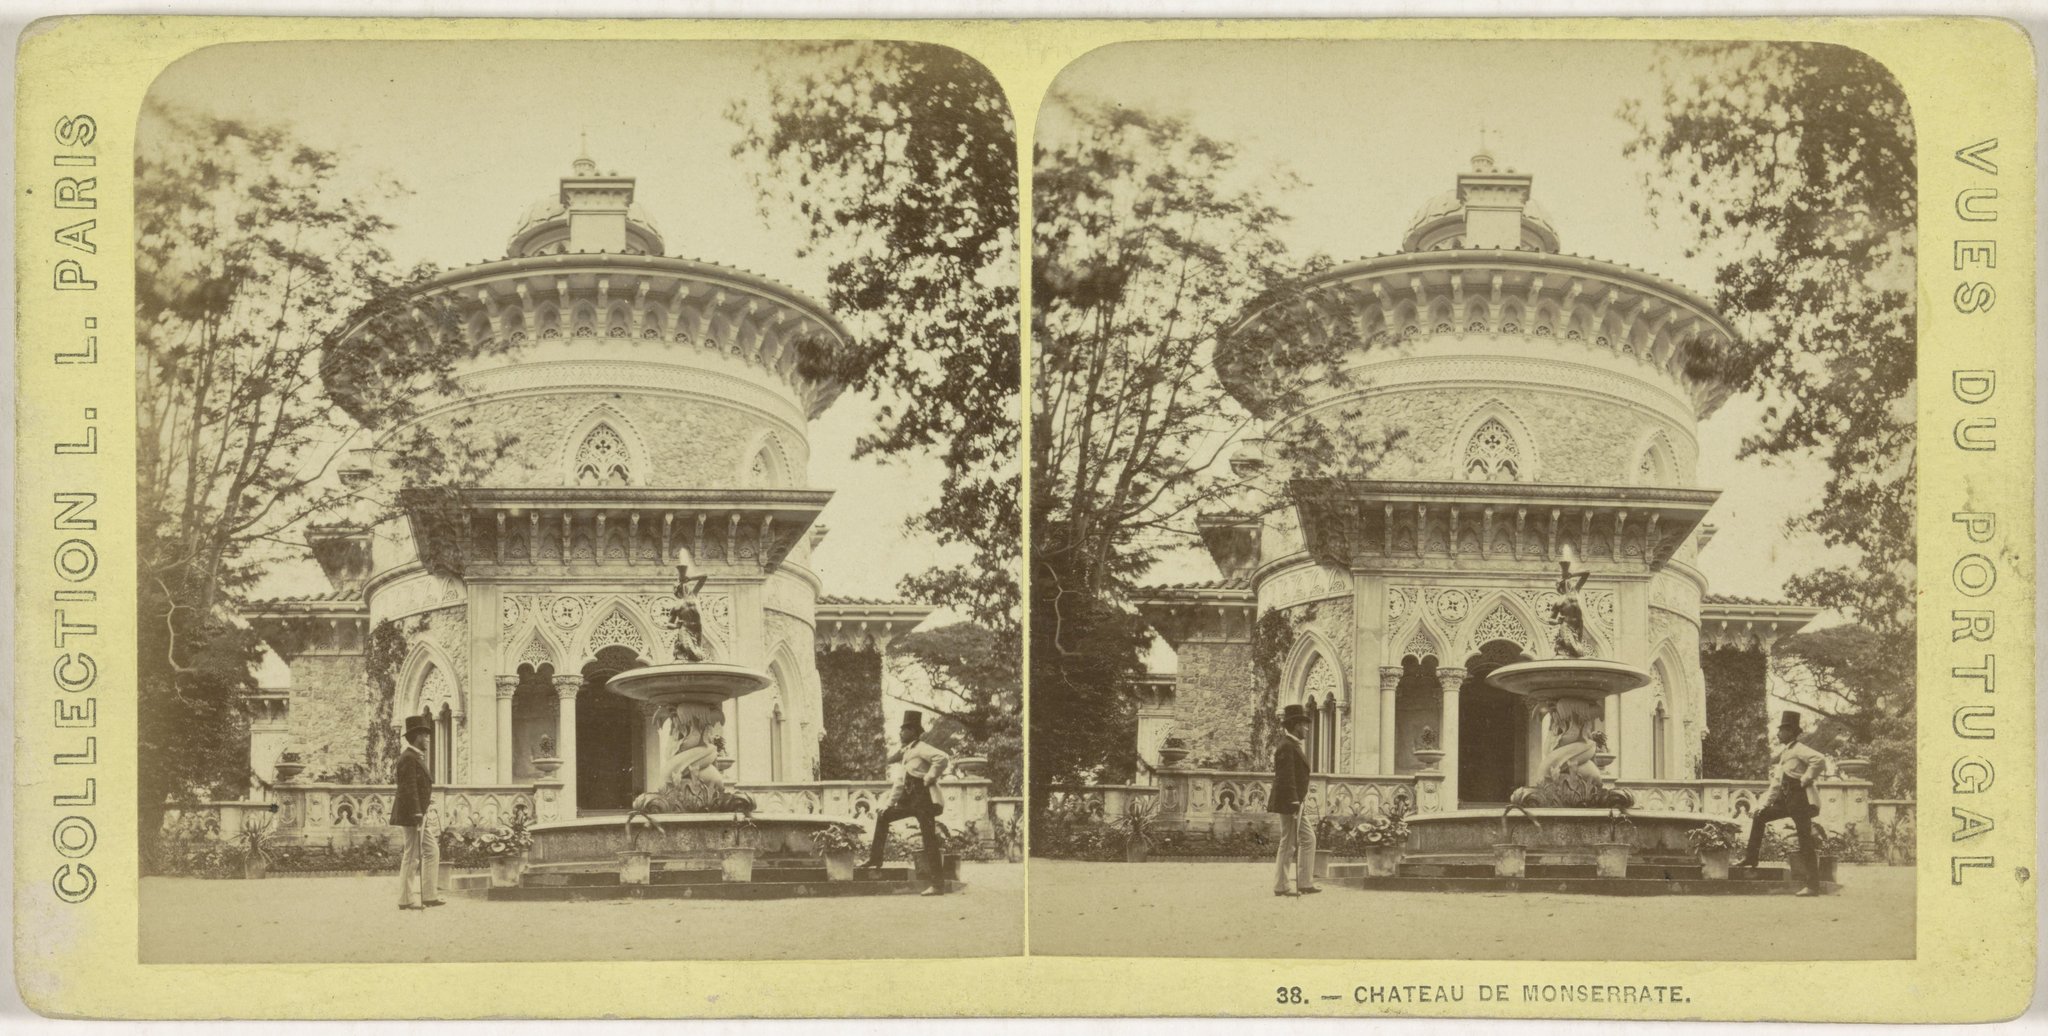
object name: stereograph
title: Palácio de Monserrate, Sintra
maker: Anonymous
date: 1868-1890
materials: cardboard, paper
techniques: albumen print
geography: paris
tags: palace, monserrate palace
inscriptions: number: ‘38.’